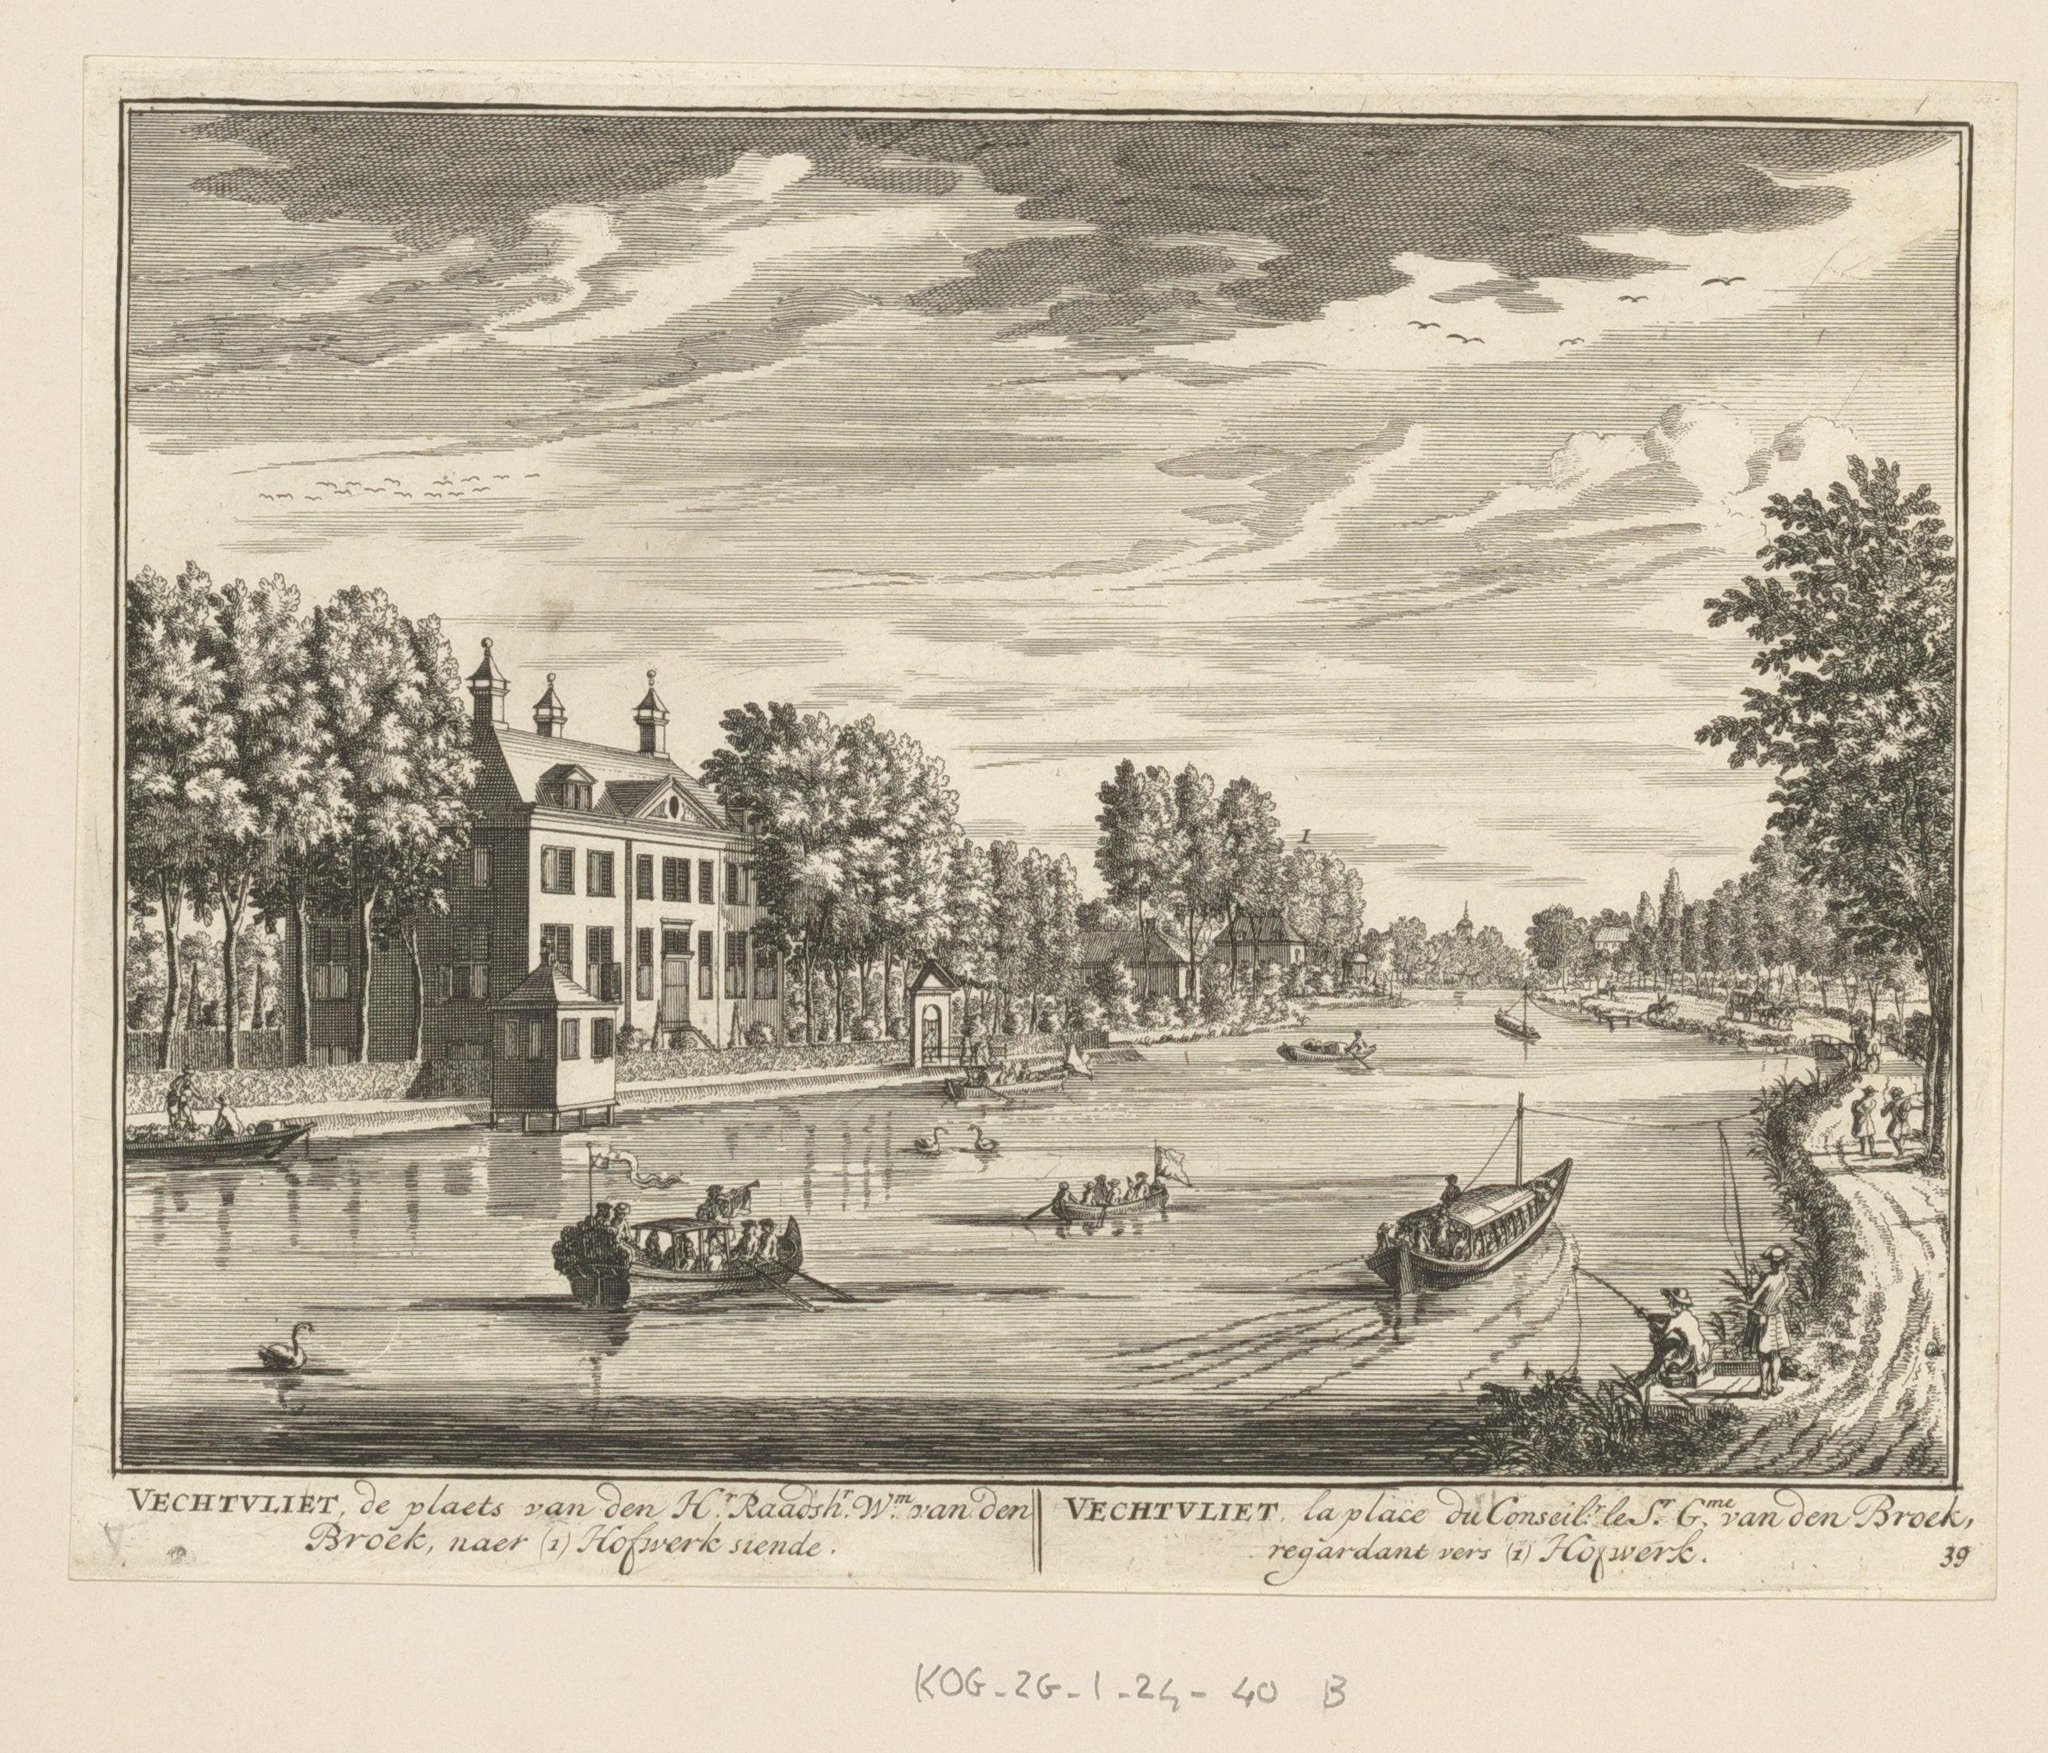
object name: book illustration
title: Vechtvliet de plaets van den H. Raadsh. W. van den Broek, naer (1) Hofwerk siende / Vechtvliet la place du Conseil: le S. G. van den Broek, regardant vers (1) Hofwerk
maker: daniël stopendaal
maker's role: print maker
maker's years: 1672-1726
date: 1719-1790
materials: paper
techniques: engraving, etching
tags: river (+ landscape with figures, staffage), country-house, vecht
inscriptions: collector's mark: Lugt 1641, stamp, stamp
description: Prent mogelijk uit: Leth, Andries de. De zegepraalende Vecht, vertoonende verscheidene gesichten van lustplaatsen, heeren huysen en dorpen, beginnende van Uitrecht en met Muyden besluytende (...). Amsterdam: Weduwe Nicolaus Visscher, 1719. Of uit: Brouërius van Nidek, Matthaeus. De Vechtstroom, van Utrecht tot Muiden (...). Amsterdam: H. Gartman, W. Vermandel en J.W. Smit, 1790.